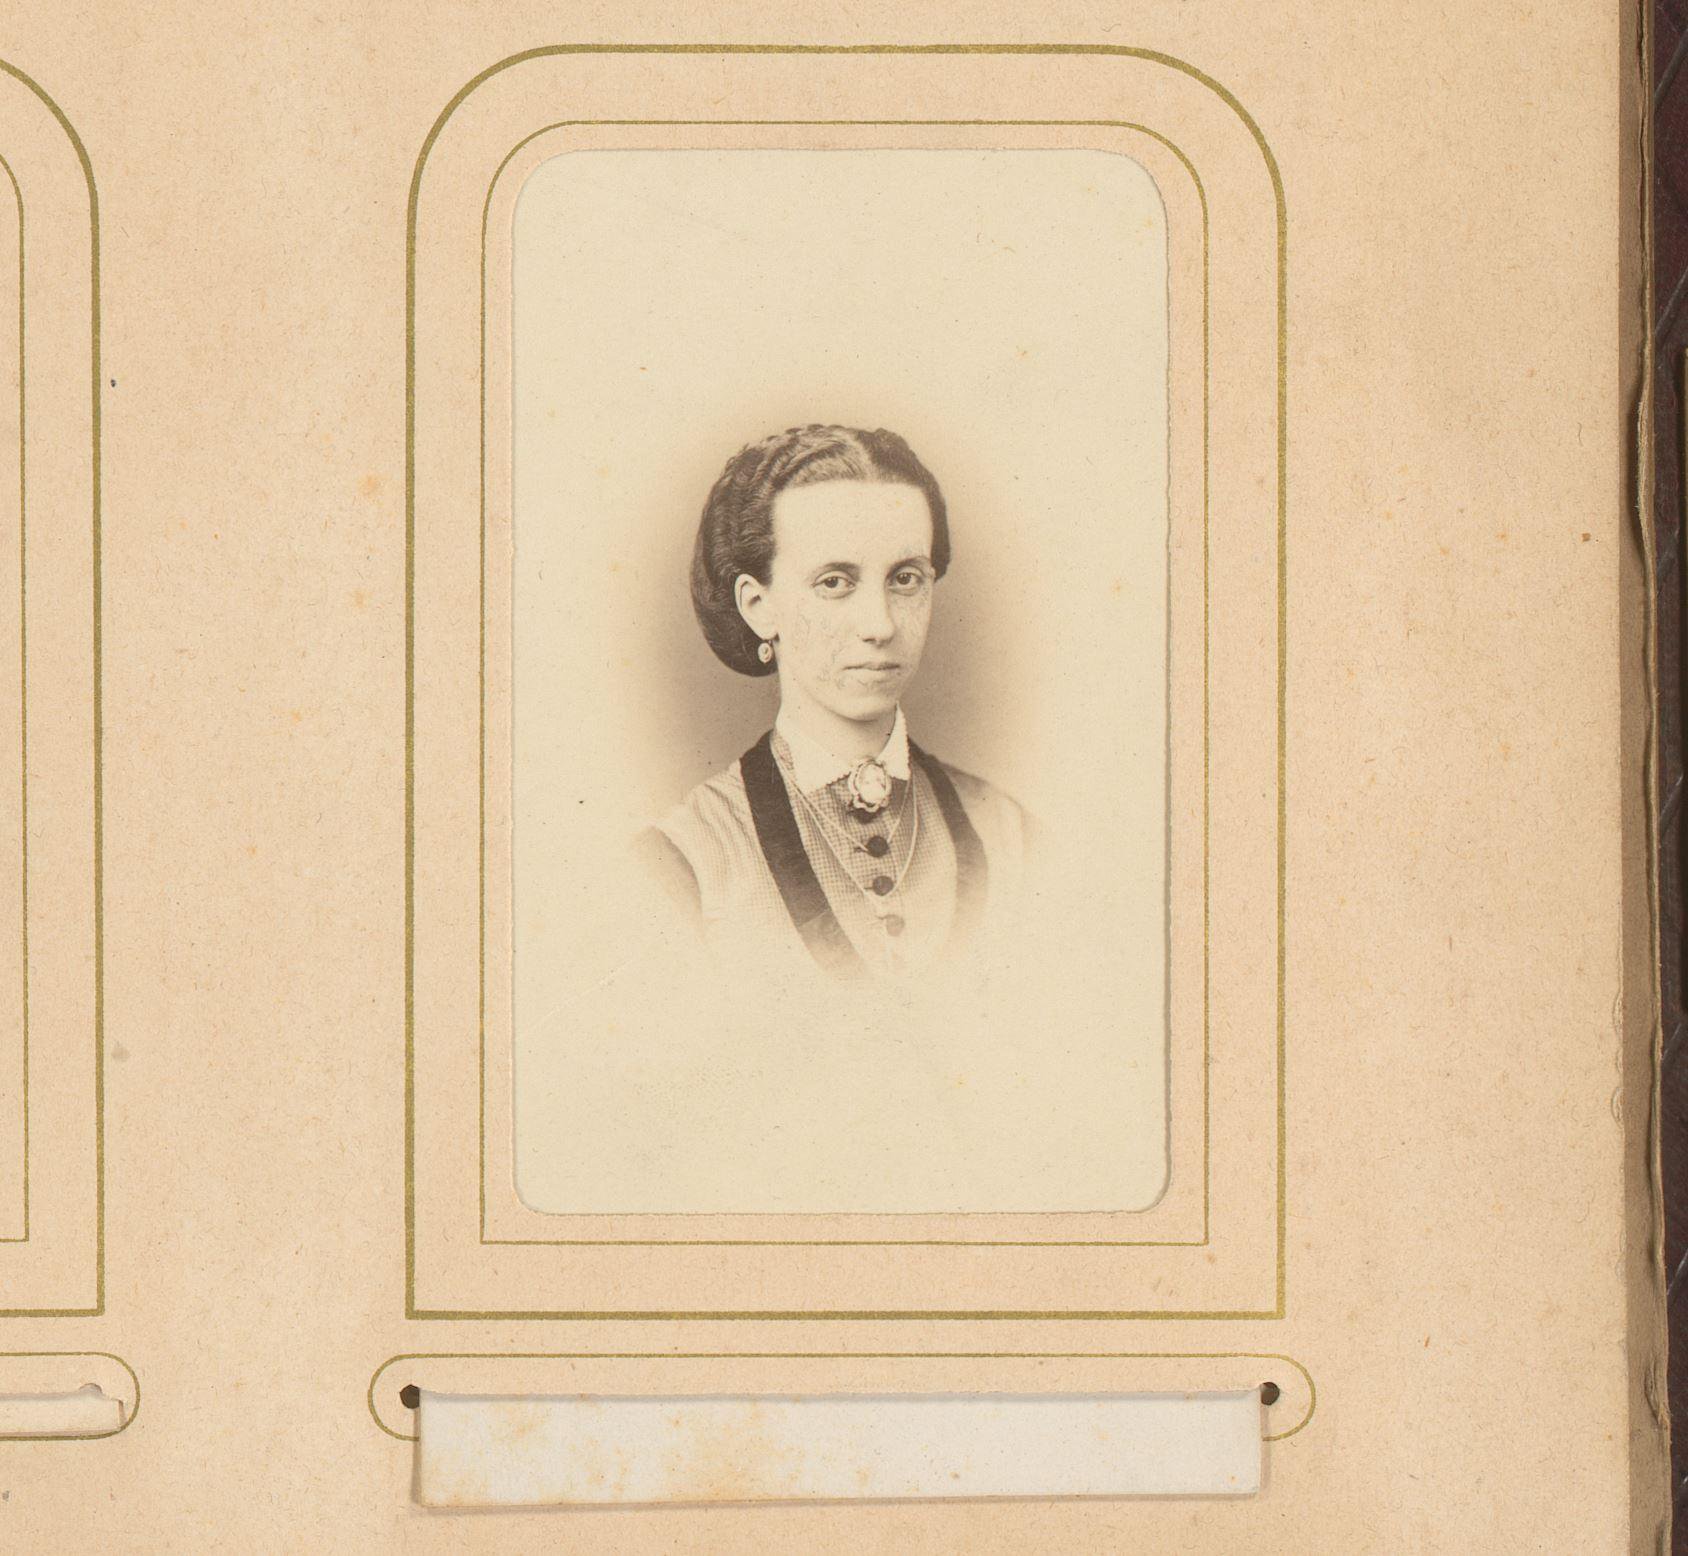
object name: carte de visite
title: Portret van een vrouw met halsketting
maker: a. böeseken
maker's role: fotograaf, lithograaf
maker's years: 1834-1919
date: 1858-1890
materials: cardboard, photographic support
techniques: albumen print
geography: rotterdam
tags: historical persons - bb - woman, necklace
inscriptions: inscription: ‘A. Böeseken/ Photographisch Atelier/ ROTTERDAM/ Hoogstraat over de Vlasmarkt’